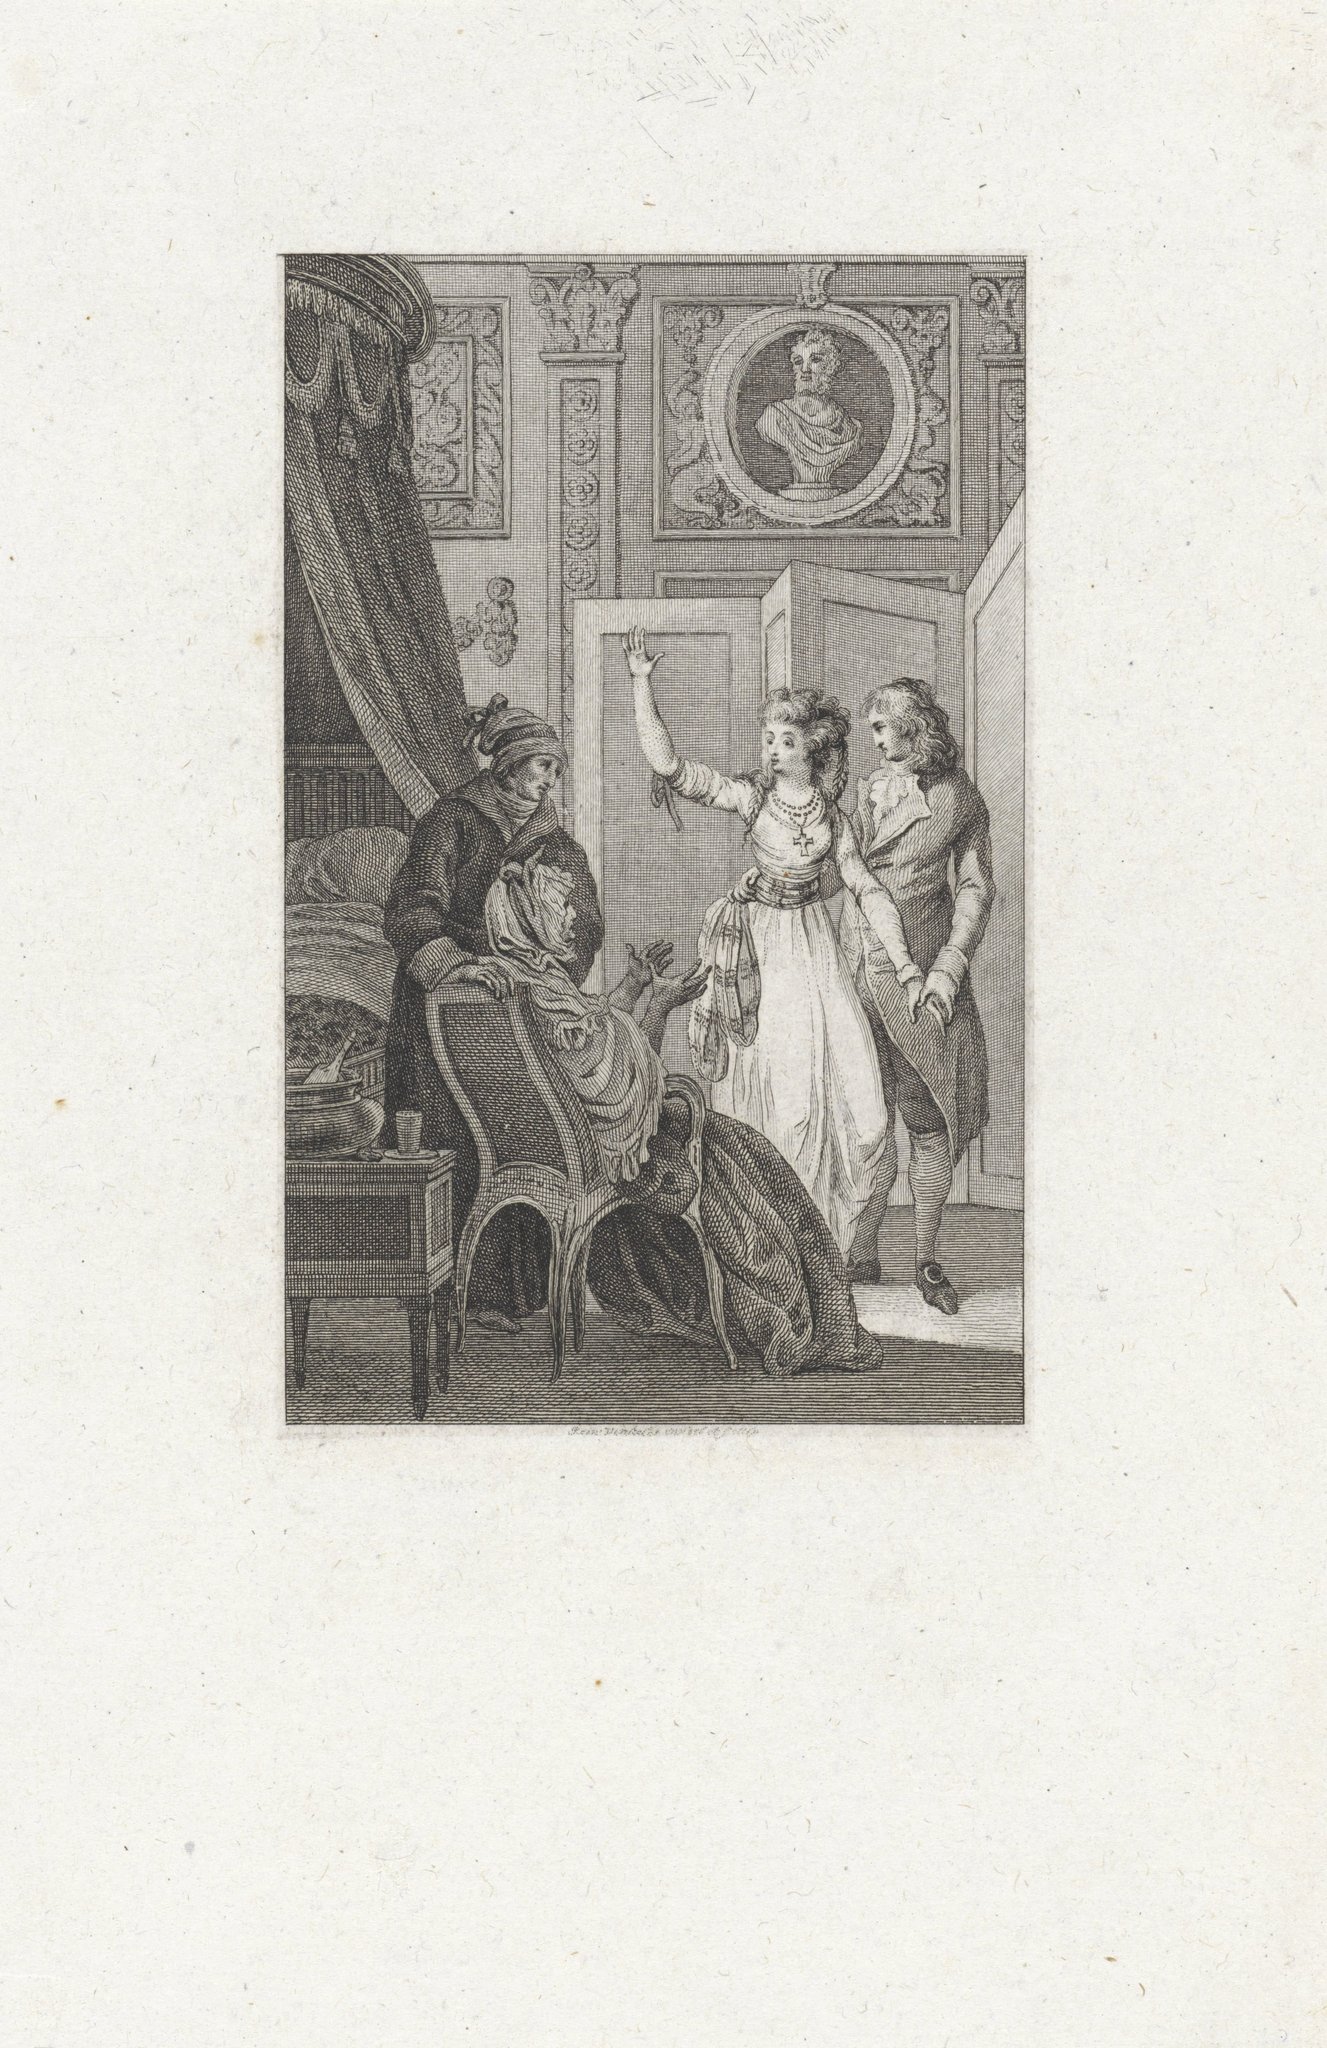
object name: print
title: Jong paar in gesprek met een oudere man en vrouw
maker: reinier vinkeles (i)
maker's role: draughtsman, print maker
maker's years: 1741-1816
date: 1798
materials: paper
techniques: engraving, etching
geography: amsterdam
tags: arm raised upward, conversation, dialogue; conversation piece, couple of lovers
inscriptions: collector's mark: Lugt 240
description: Illustratie uit: Richardson, Samuel. Geschiedenis van Karel Grandison. Amsterdam: Johannes Allart, 1797-1802.